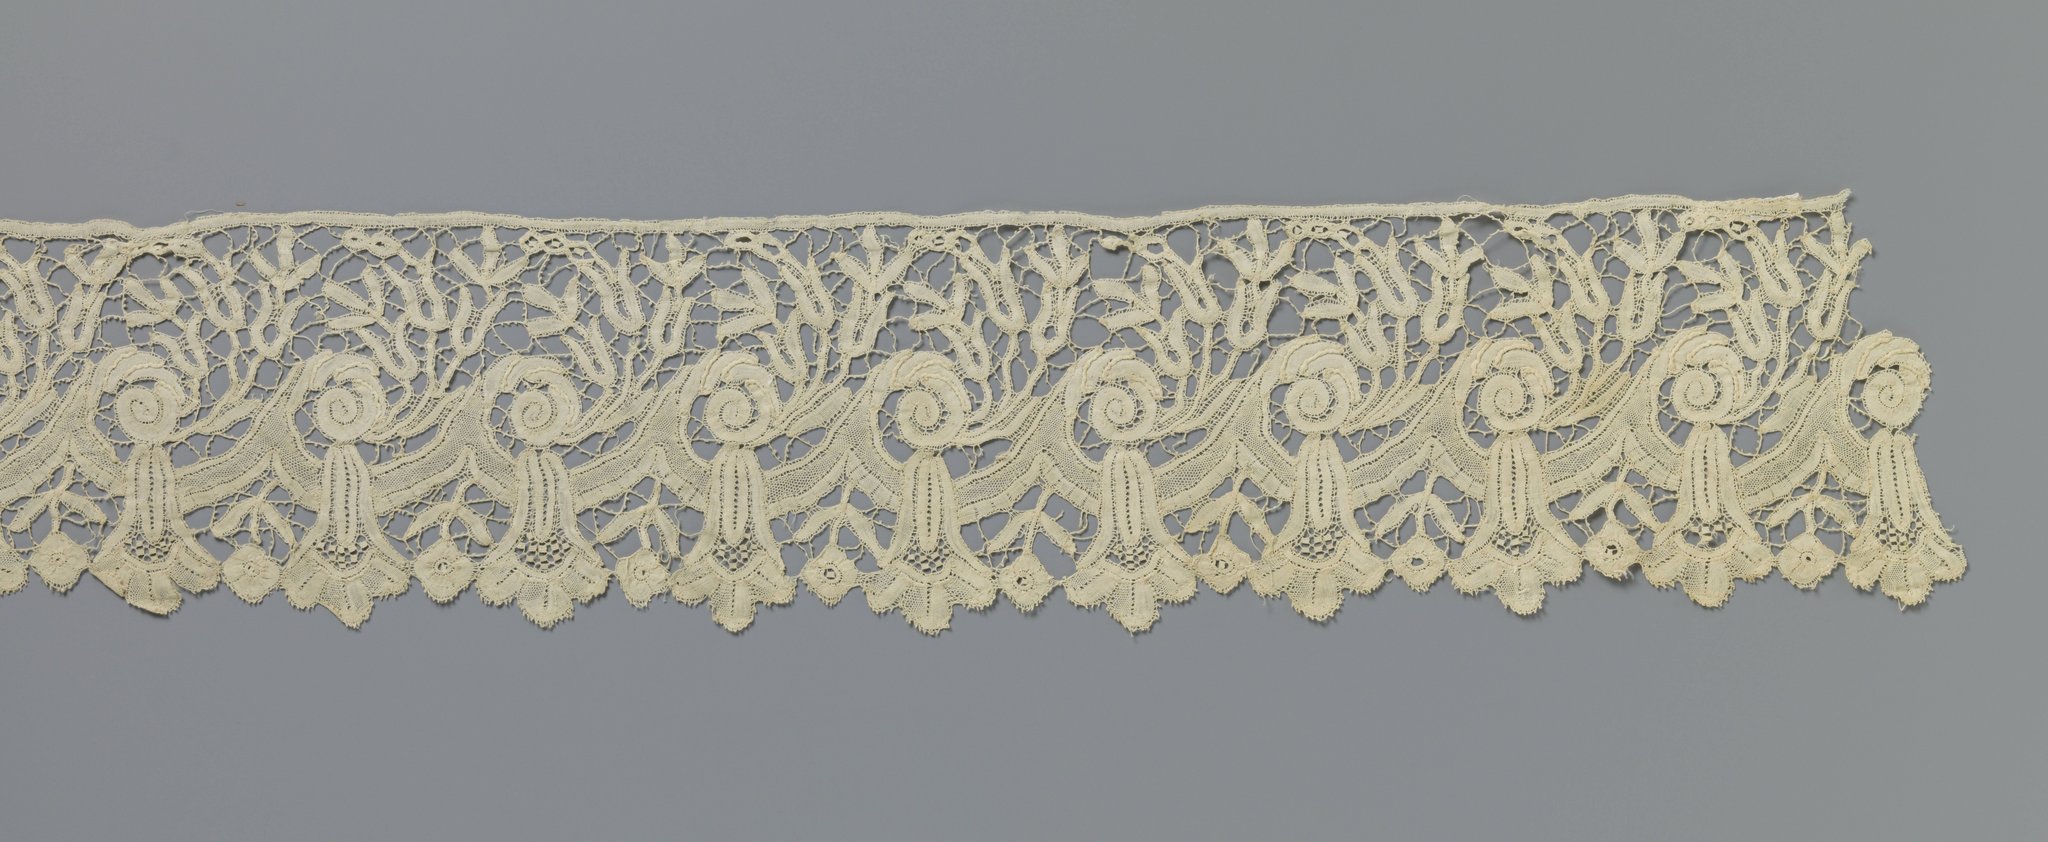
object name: strip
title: Strook kloskant met kelkbloem onder overslaande golf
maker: Anonymous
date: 1840-1860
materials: cotton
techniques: lace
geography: honiton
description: Strook naturelkleurige kloskant, Honiton-kant. Het zich herhalende en doorlopende patroon bestaat uit een band die overslaande golven vormt, met onder elke schuimkop een hangende smalle kelkbloem. Tussen de opeenvolgende kelken hangt vanuit de golvende band een rozetbloempje aan een steel met twee blaadjes. Naar boven toe ontspringen vanaf de omslaande golf drie stelen met aan elk een kleinere kelkbloem. De motieven zijn met elkaar verbonden door een vlechtengrond, met gepicoteerde vlechtjes. Ze zijn gemaakt in linnenslag en netslag met opengewerkte randjes. In elke golftop zijn drie reliëfcontourlijnen aangebracht. In de kelkbloemen is een siergrond met vierkante motiefjes in vormslag toegepast. De bovenzijde van de strook is recht afgewerkt met een bandje in linnenslag. De schulprand langs de onderzijde komt voort uit de bloemblaadjes van de kelkbloemen en rozetbloempjes en is afgewerkt met picots.